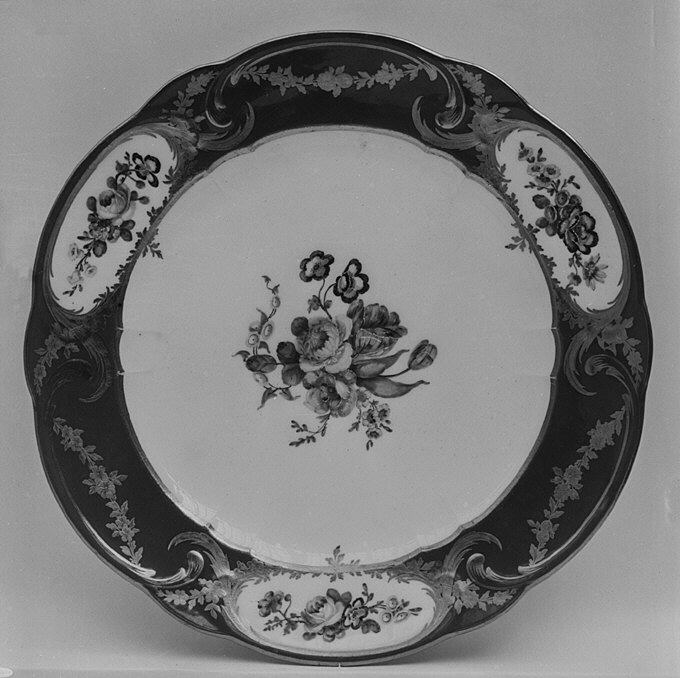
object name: plate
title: Plate (assiette à palmes) (1 of 102) (part of a service)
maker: sèvres manufactory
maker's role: manufactory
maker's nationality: french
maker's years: 1740-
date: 1772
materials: soft paste porcelain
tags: flowers